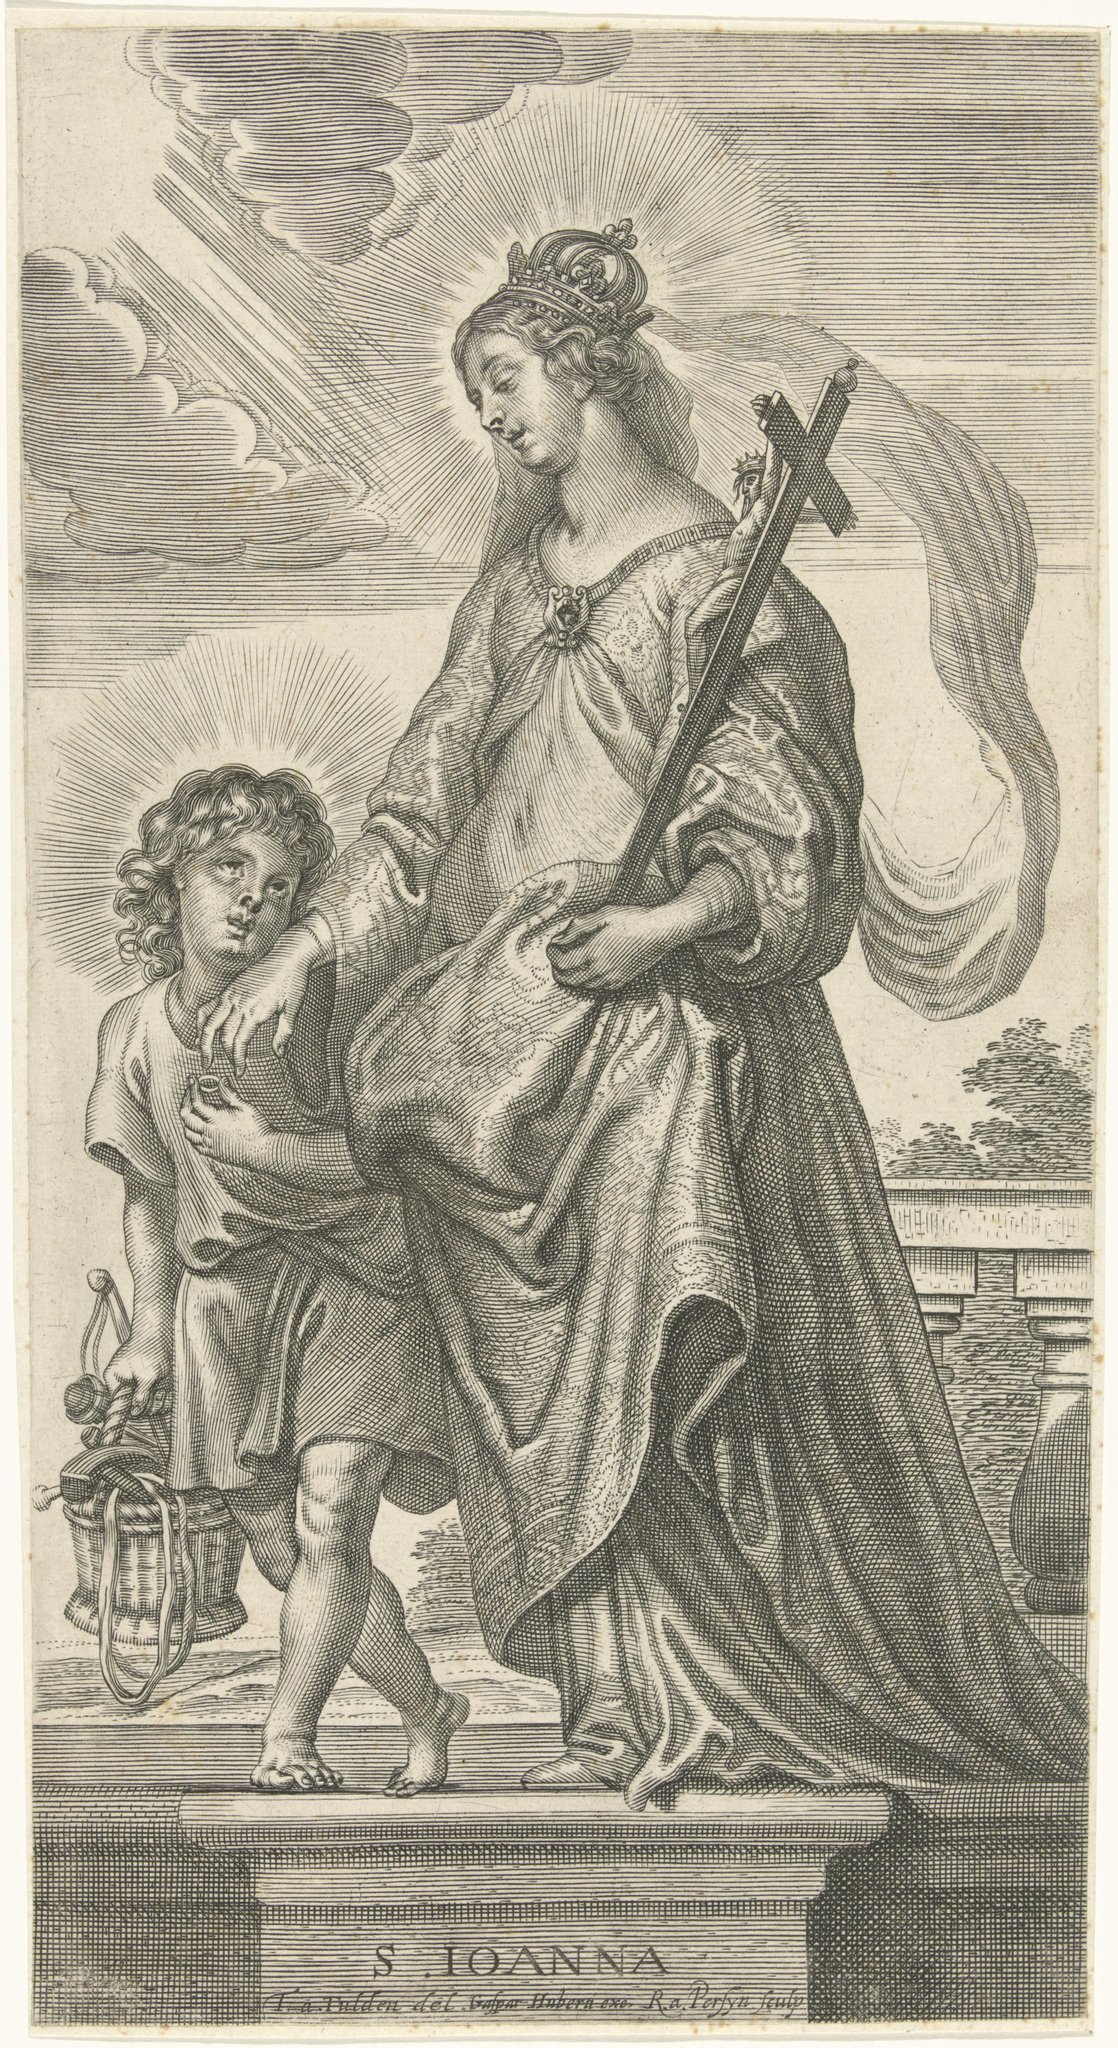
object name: print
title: H. Johanna van Valois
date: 1623-1668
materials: paper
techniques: engraving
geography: gouda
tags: christ-child carrying the instruments of the passion, female saints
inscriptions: collector's mark: Lugt 2228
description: De Heilige Johanna van Valois, gekroond en met een crucifix in de handen, ontvangt een ring van het Christuskind, dat een mand met de passiewerktuigen vasthoudt.